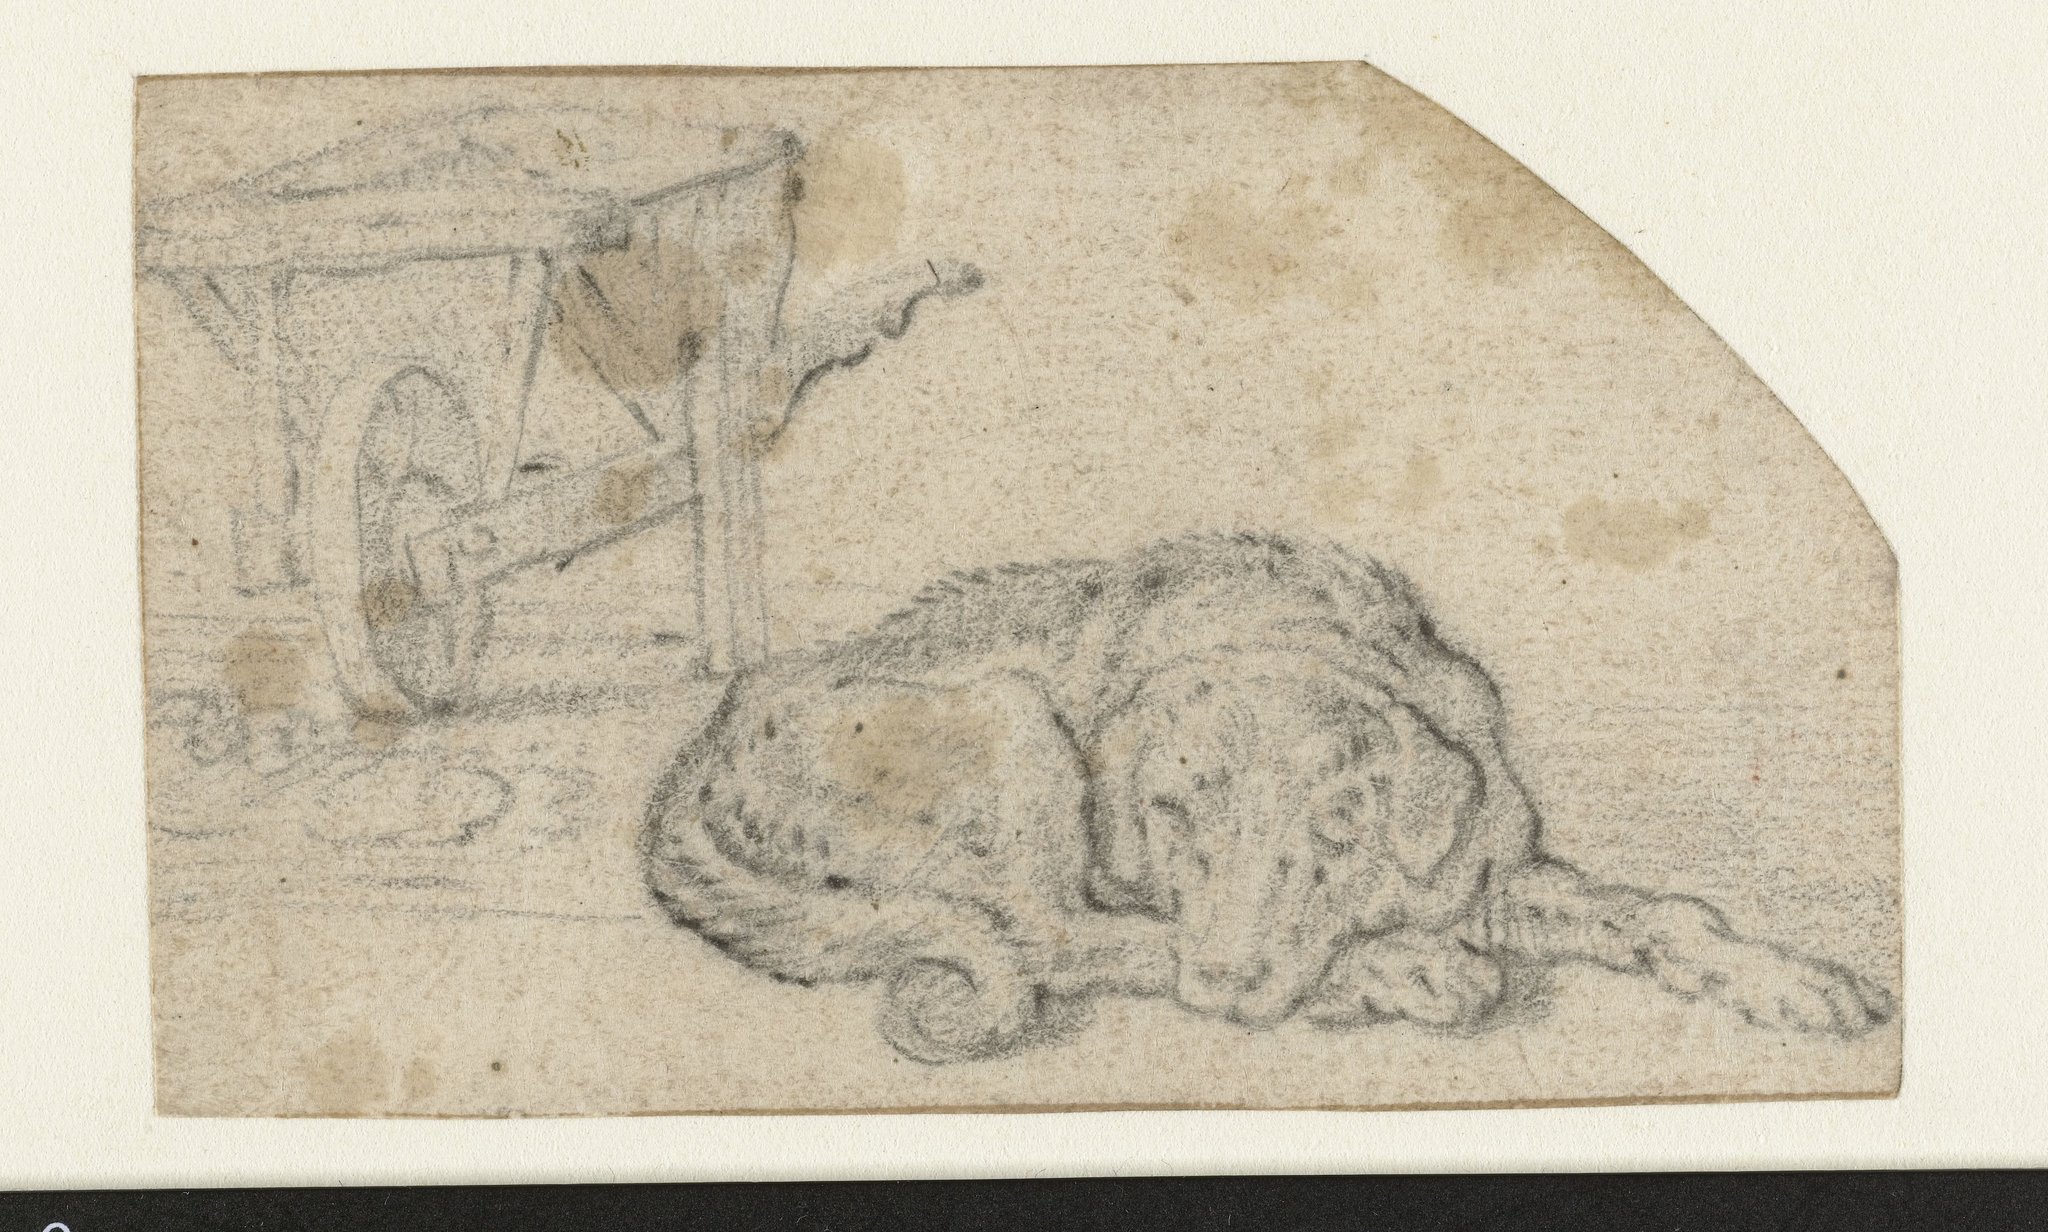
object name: drawing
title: Reclining Dog near a Wheelbarrow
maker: cornelis saftleven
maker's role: draughtsman, painter, print maker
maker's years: 1607-1681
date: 1617-1681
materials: chalk, paper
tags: wheelbarrow, dog